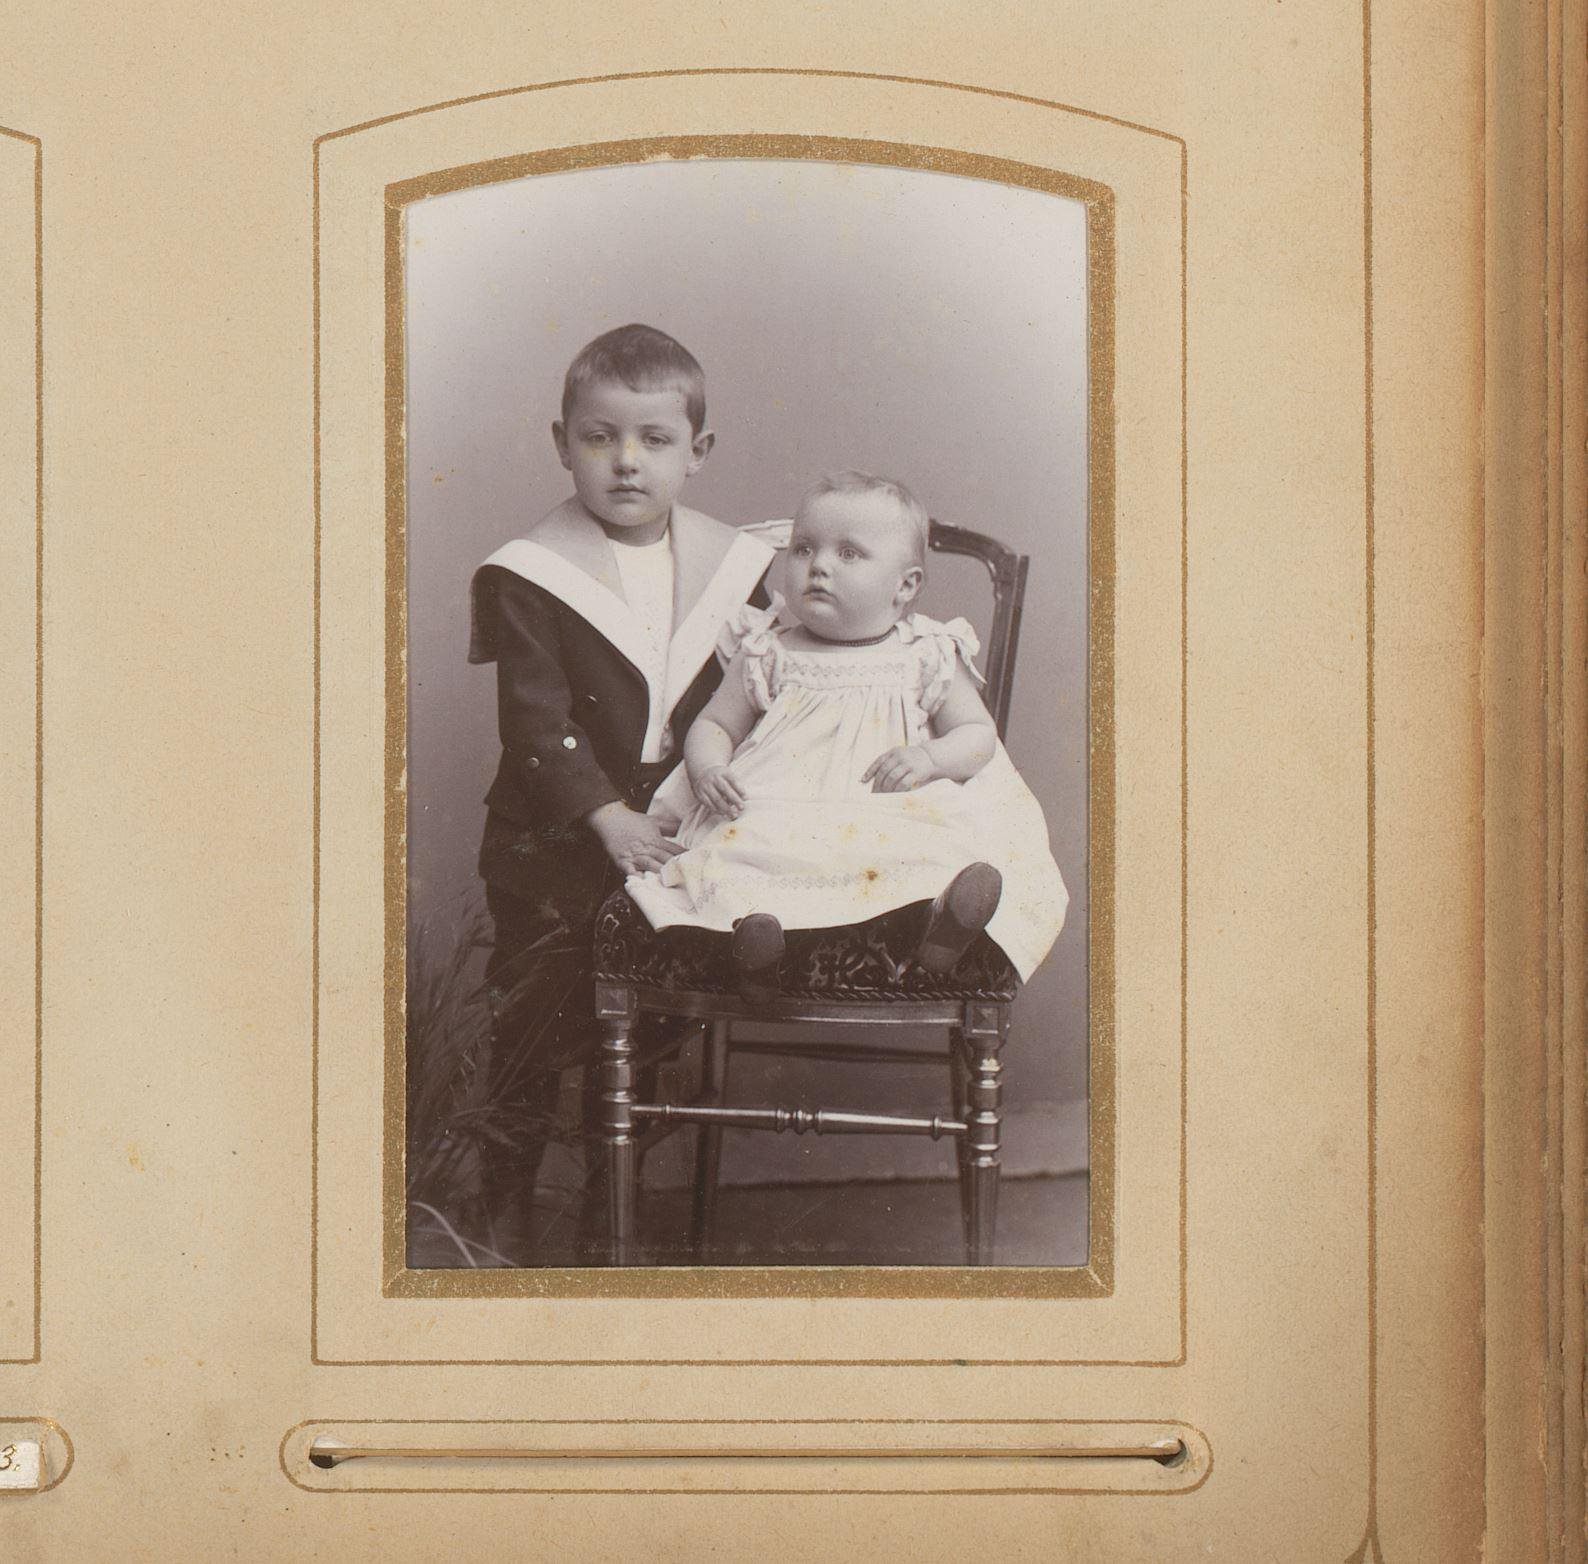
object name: carte de visite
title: Portret van een jongen met een zittende baby op een stoel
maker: adolf neumann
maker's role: fotograaf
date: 1880-1910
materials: cardboard, photographic support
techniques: collodion silver print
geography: bremen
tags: boy (child between toddler and youth), infant, baby